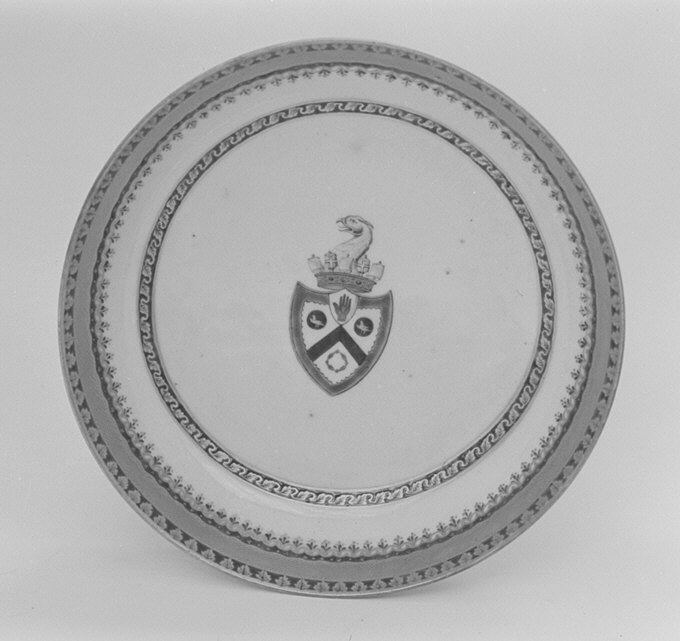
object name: saucer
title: Saucer (part of a set)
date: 1785-1800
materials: hard paste porcelain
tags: coat of arms